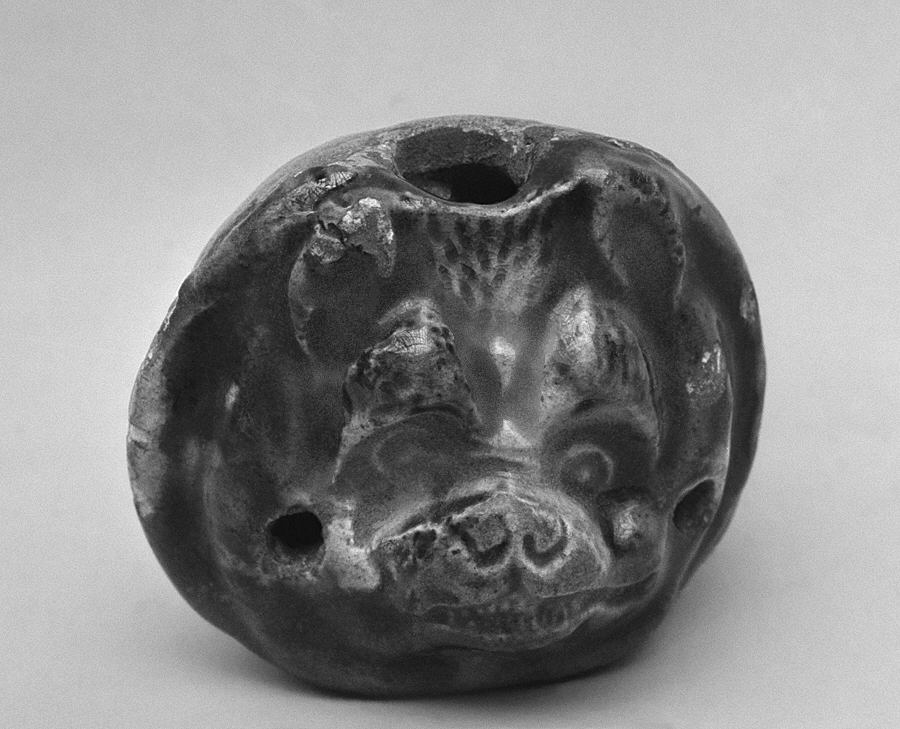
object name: ornament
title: Ornament with animal face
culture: chinese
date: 601-800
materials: earthenware, glaze